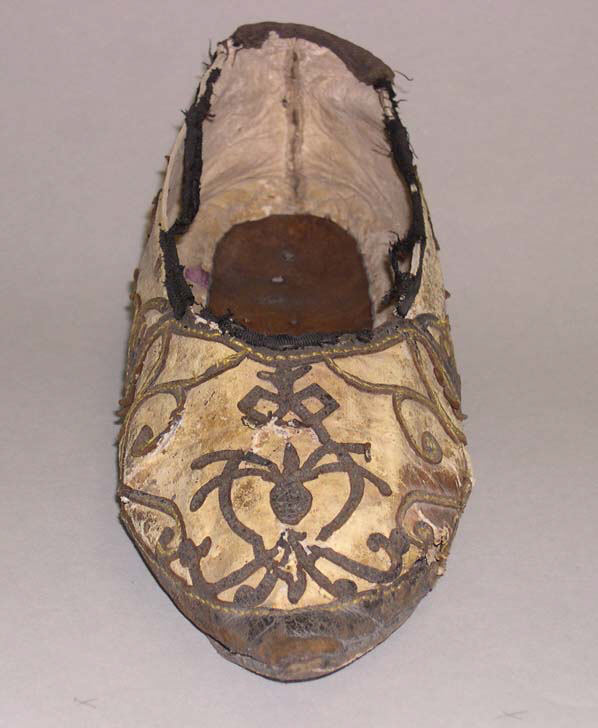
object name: slipper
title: Slippers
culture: italian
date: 1780-1799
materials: leather